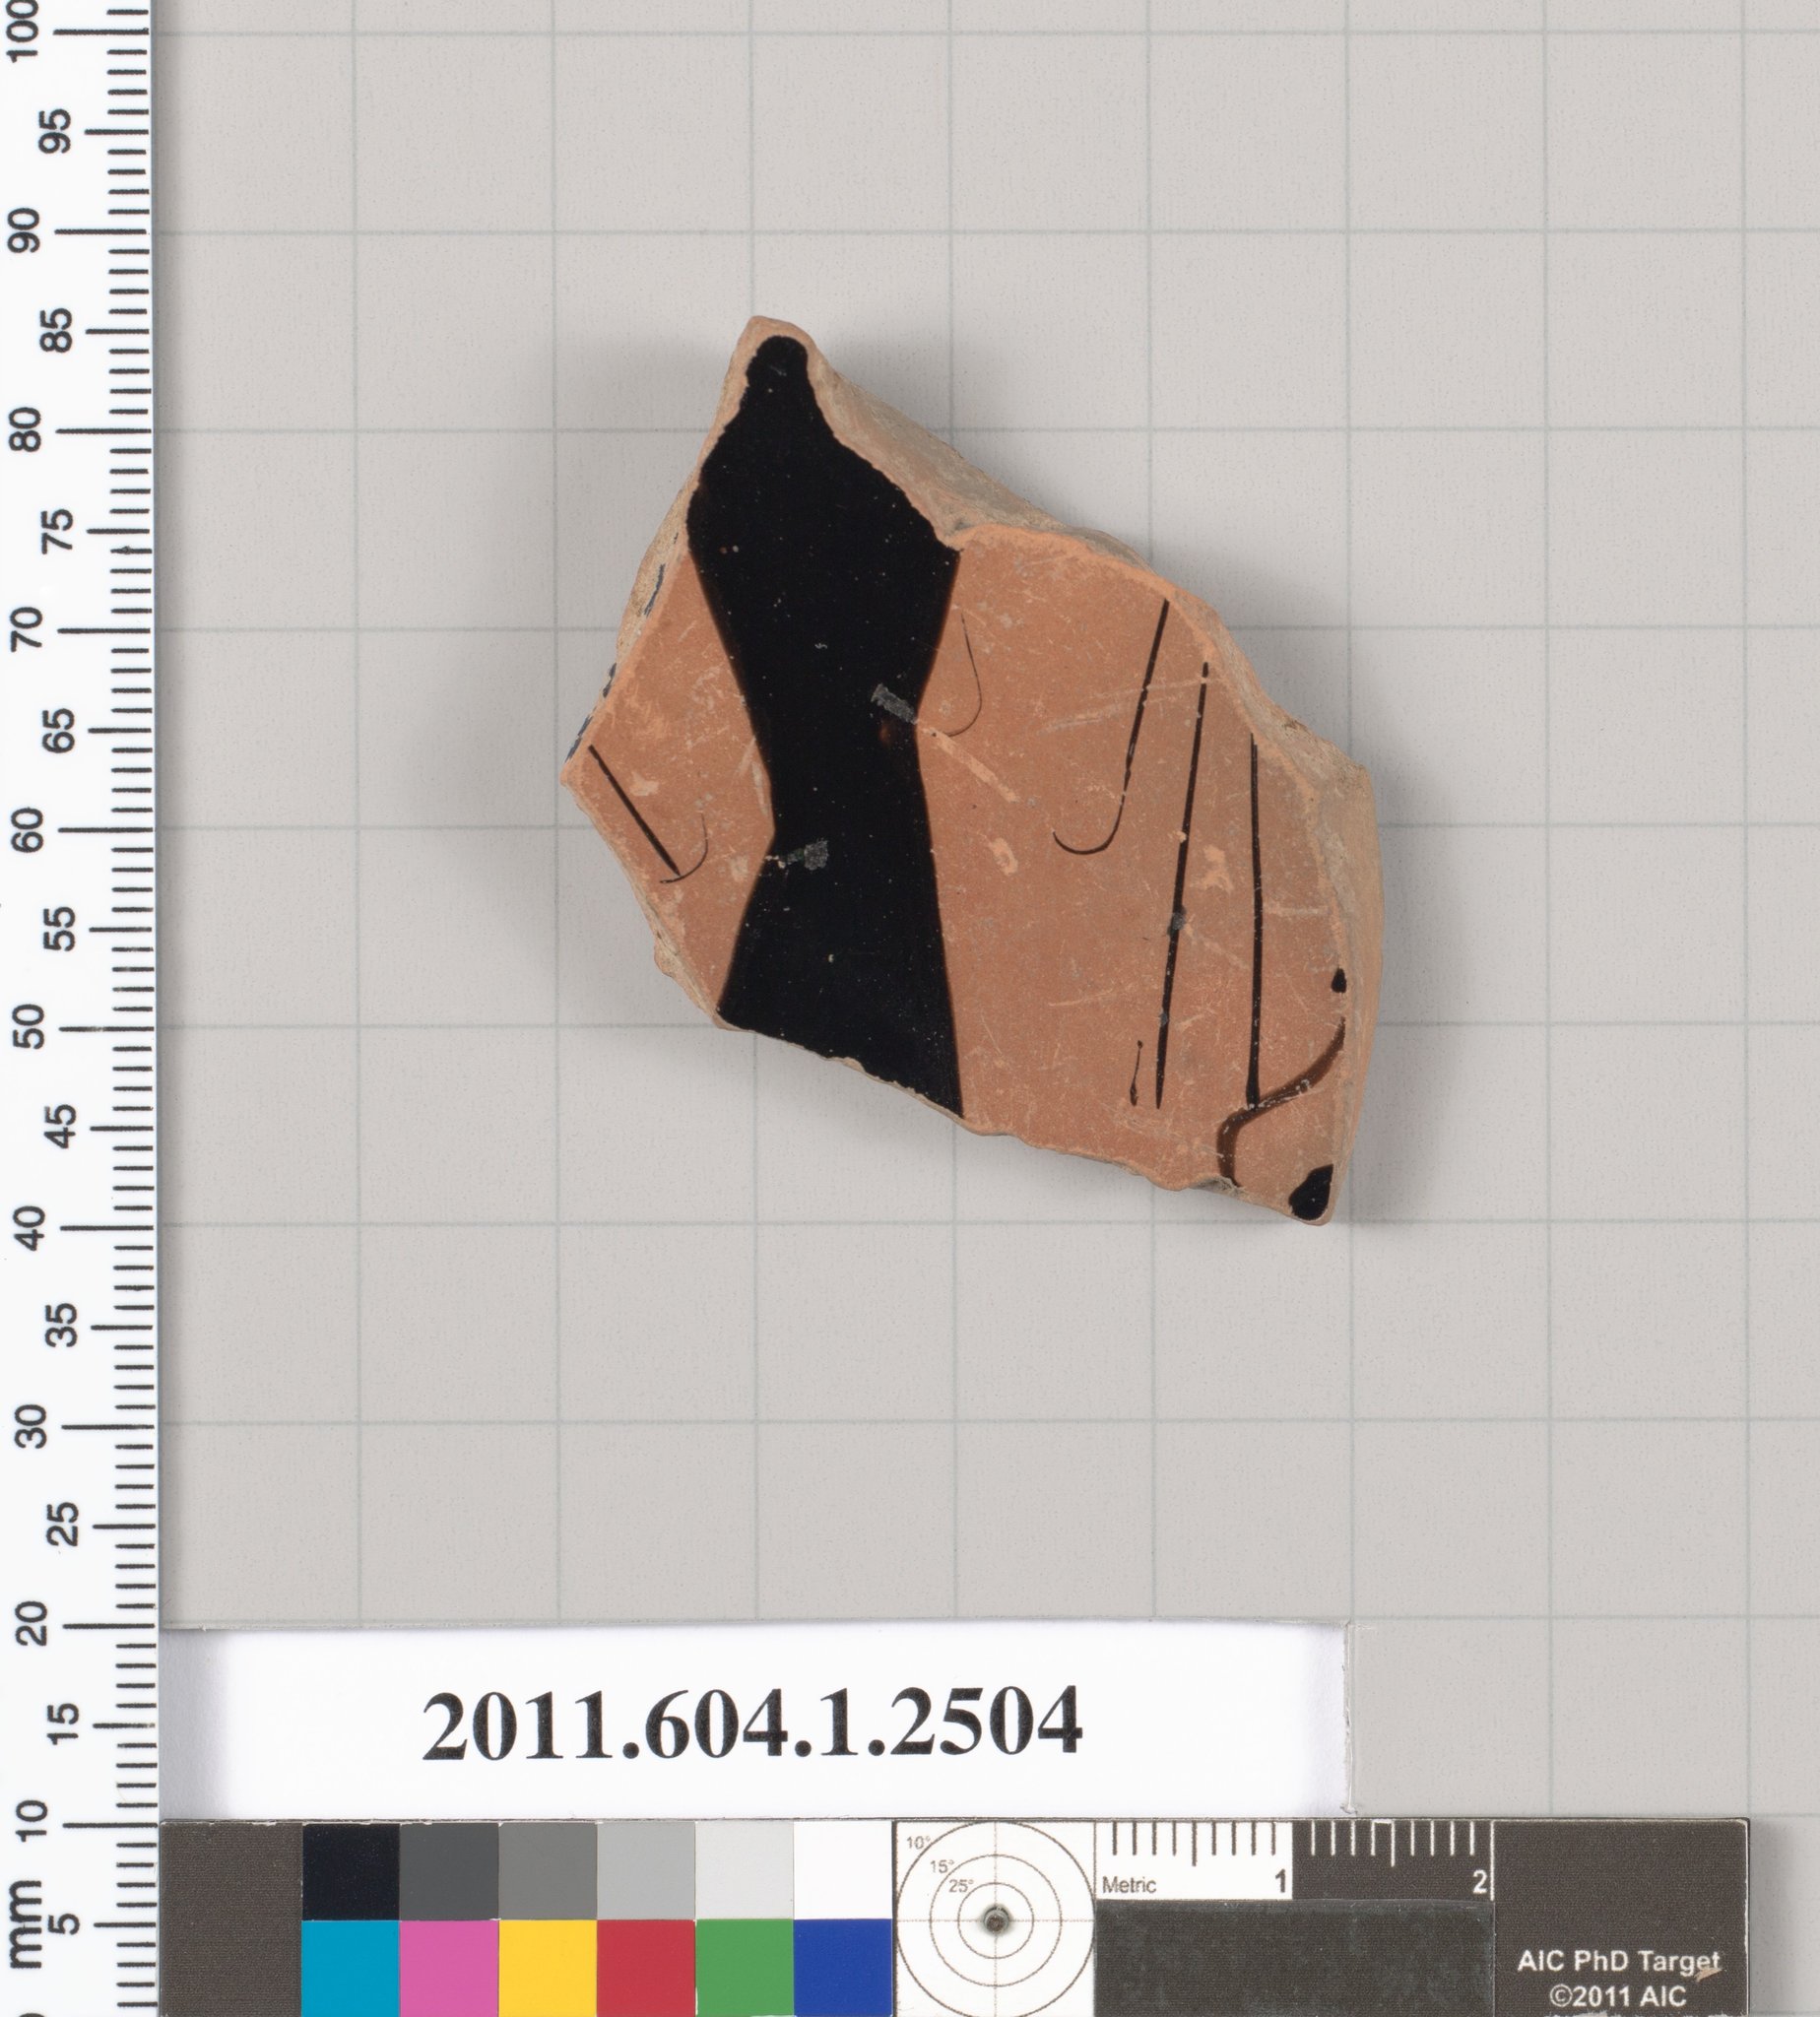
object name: kylix fragment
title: Terracotta fragment of a kylix (drinking cup)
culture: greek, attic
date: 475-451 BCE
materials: terracotta